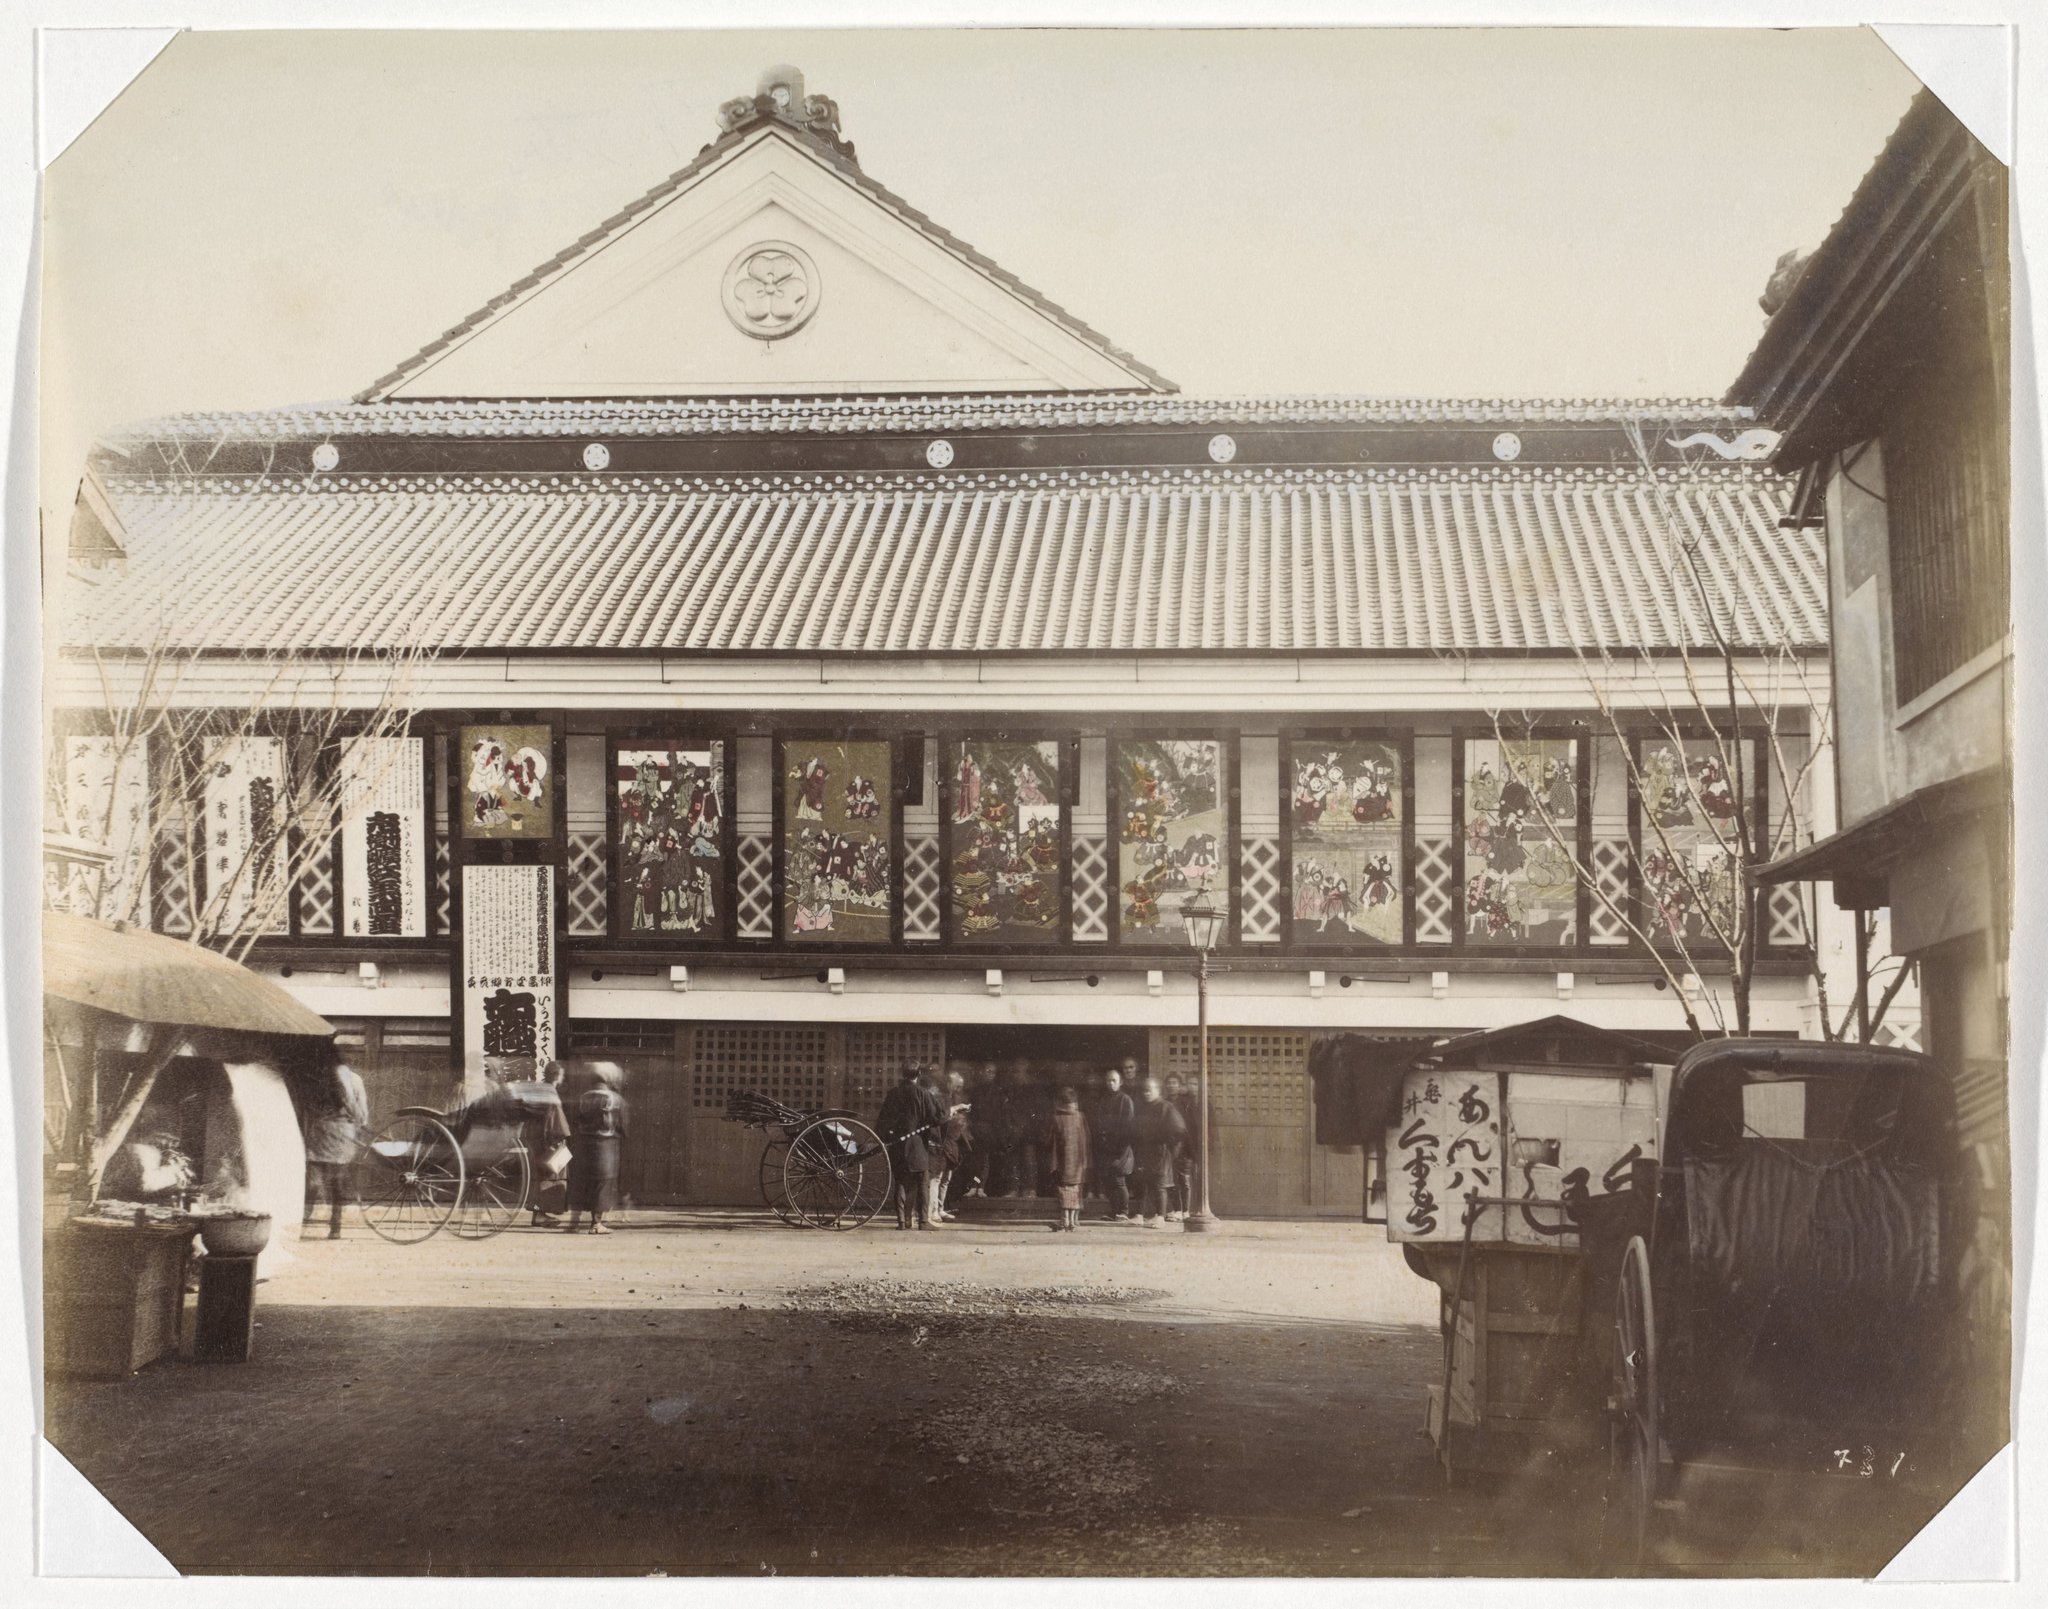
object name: photograph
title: Ingang van een theater in Kyoto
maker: Anonymous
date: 1890-1894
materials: cardboard, paper, photographic support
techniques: albumen print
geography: kyoto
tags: theatre (building), kyoto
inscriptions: negative number: ‘731’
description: Onderdeel van Album met 69 foto's van een reis door Japan.